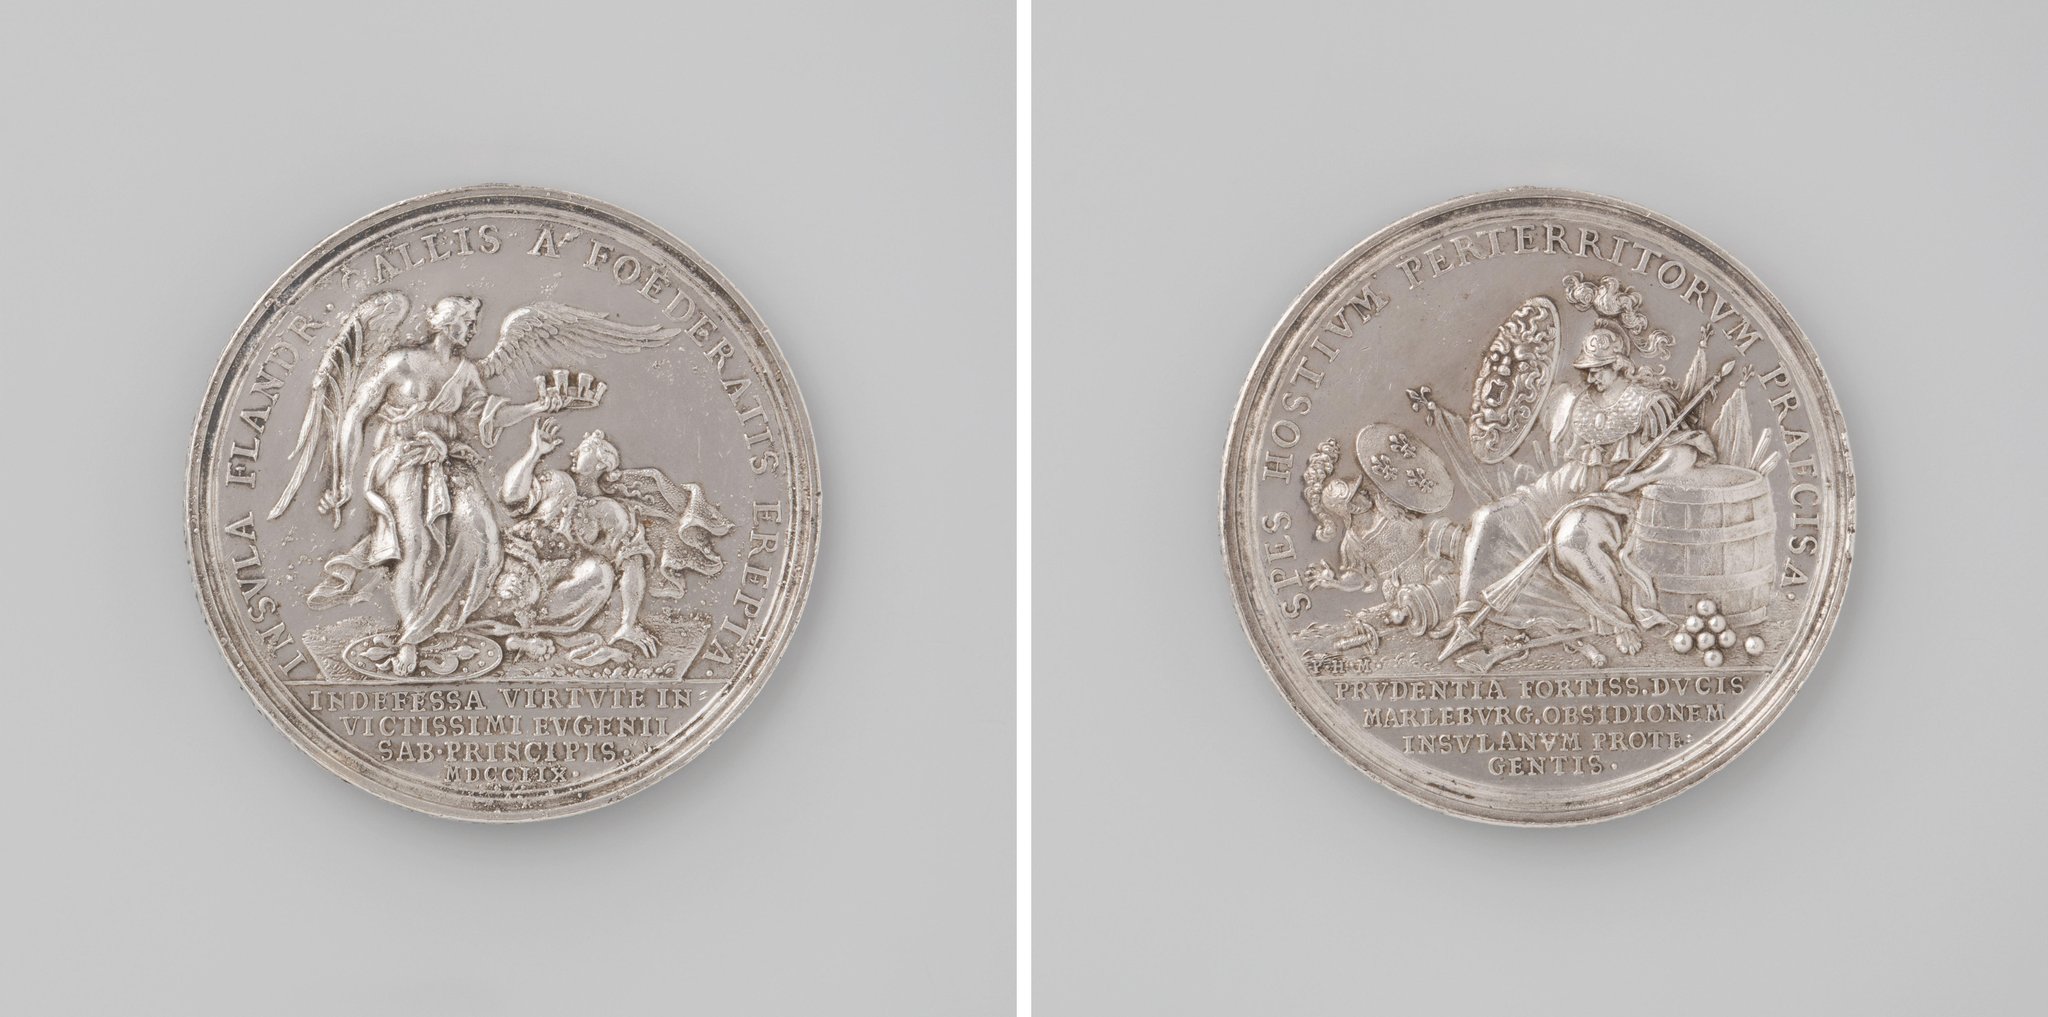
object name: history medal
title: Rijssel door de bondgenoten ingenomen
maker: philipp heinrich müller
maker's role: medailleur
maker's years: 1654-1719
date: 1708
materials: silver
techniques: striking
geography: nuremberg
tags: vienna, eugenius van savoye, john churchill (1e hertog van marlborough), lille